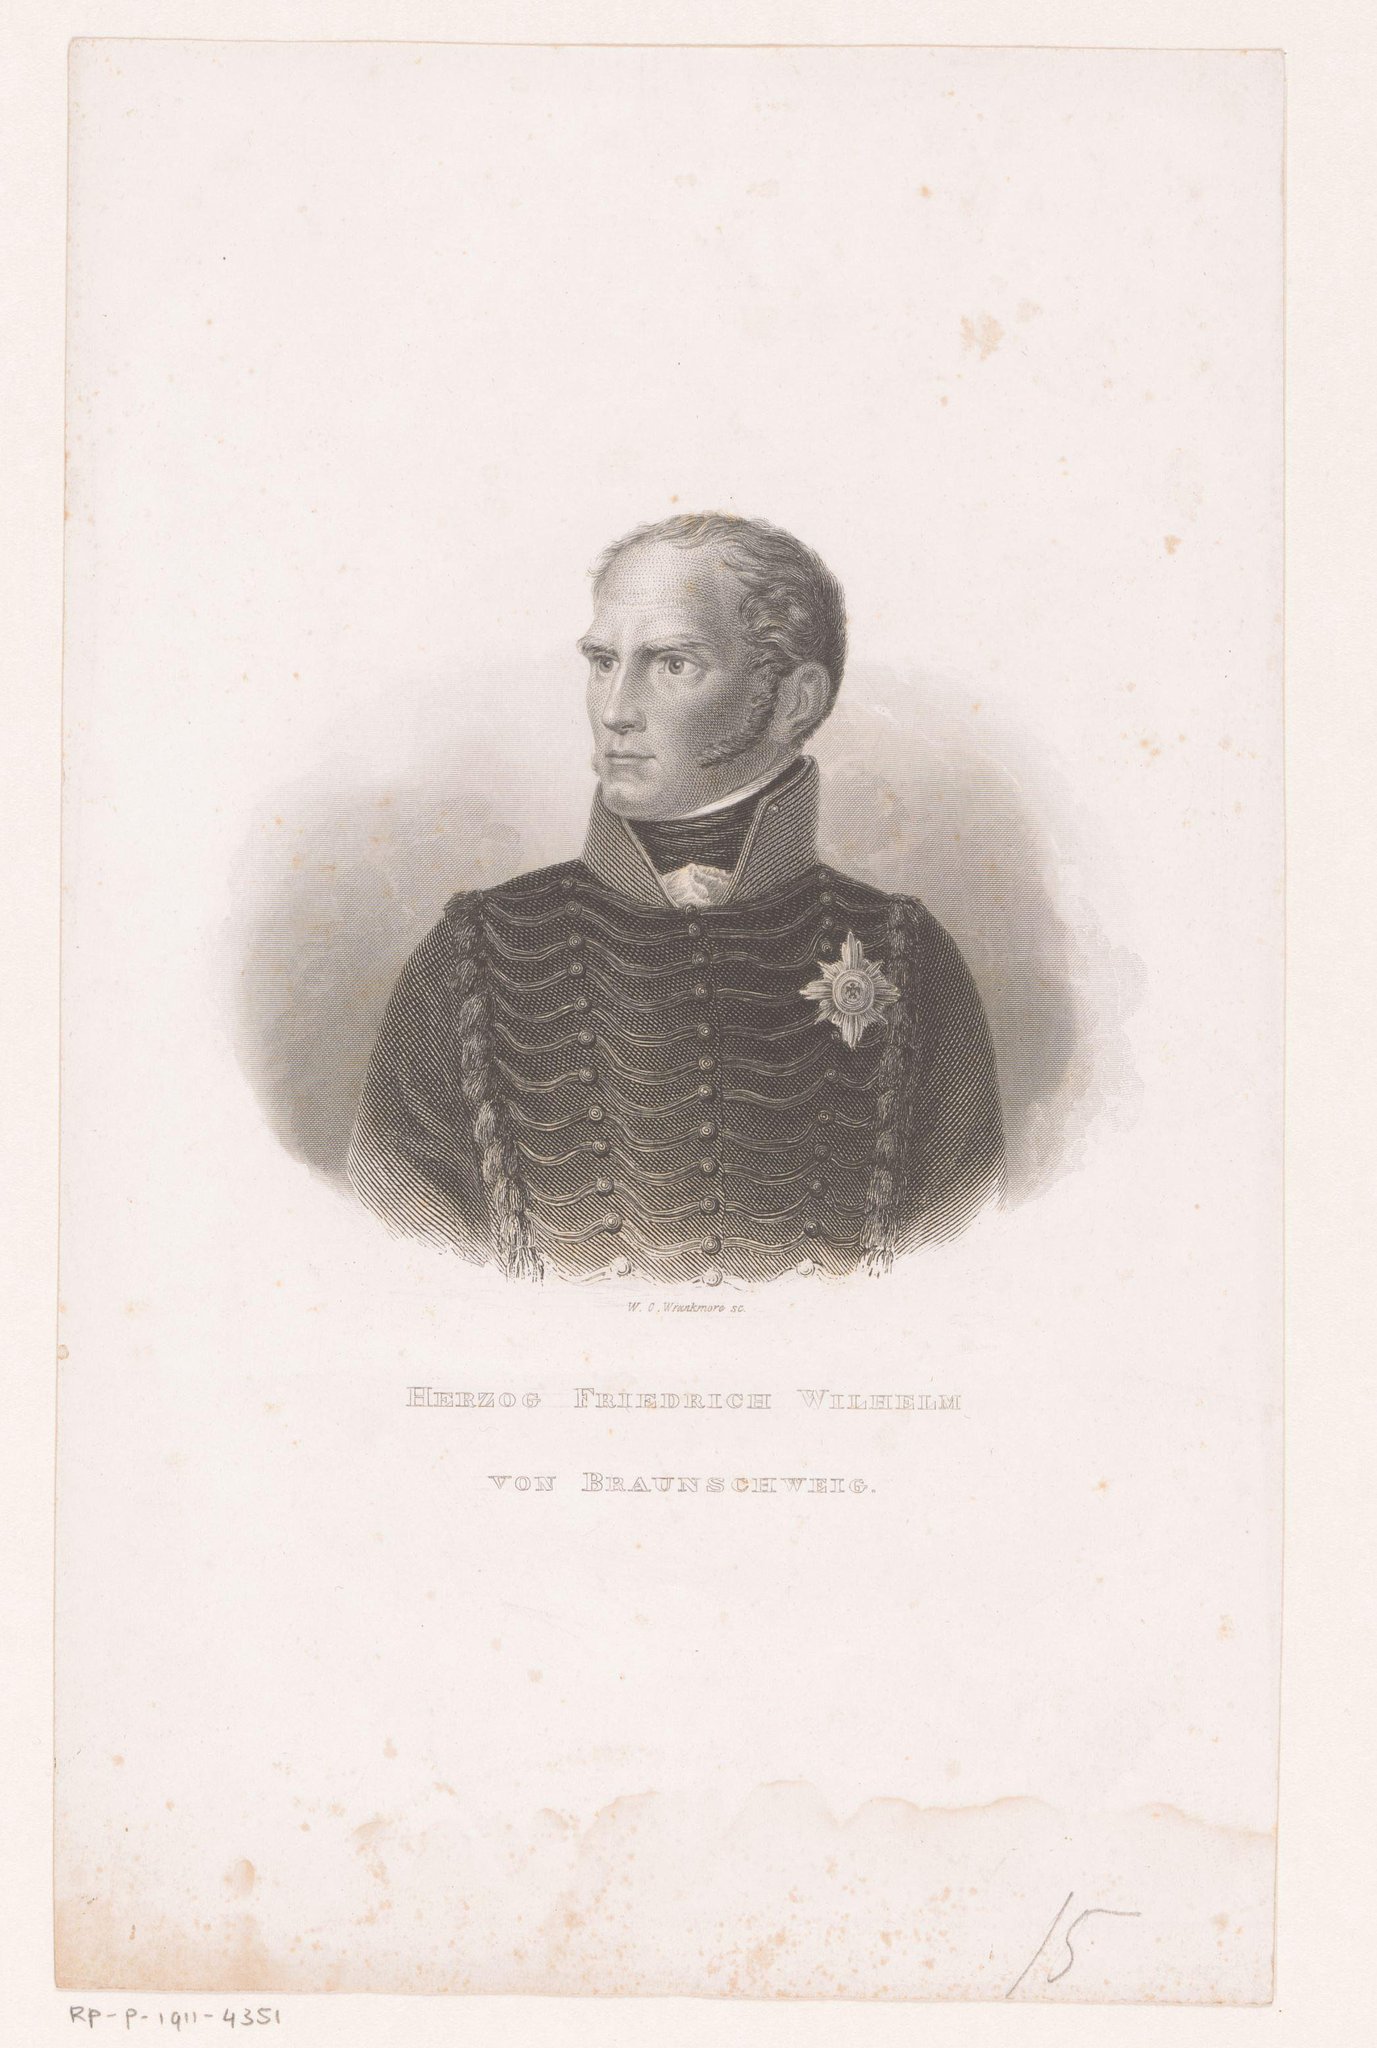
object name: print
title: Portret van Frederik Willem van Brunswijk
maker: william colley wrankmore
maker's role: print maker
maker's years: 1812-1891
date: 1826-1840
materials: paper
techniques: engraving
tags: historical persons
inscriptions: collector's mark: Lugt 2228